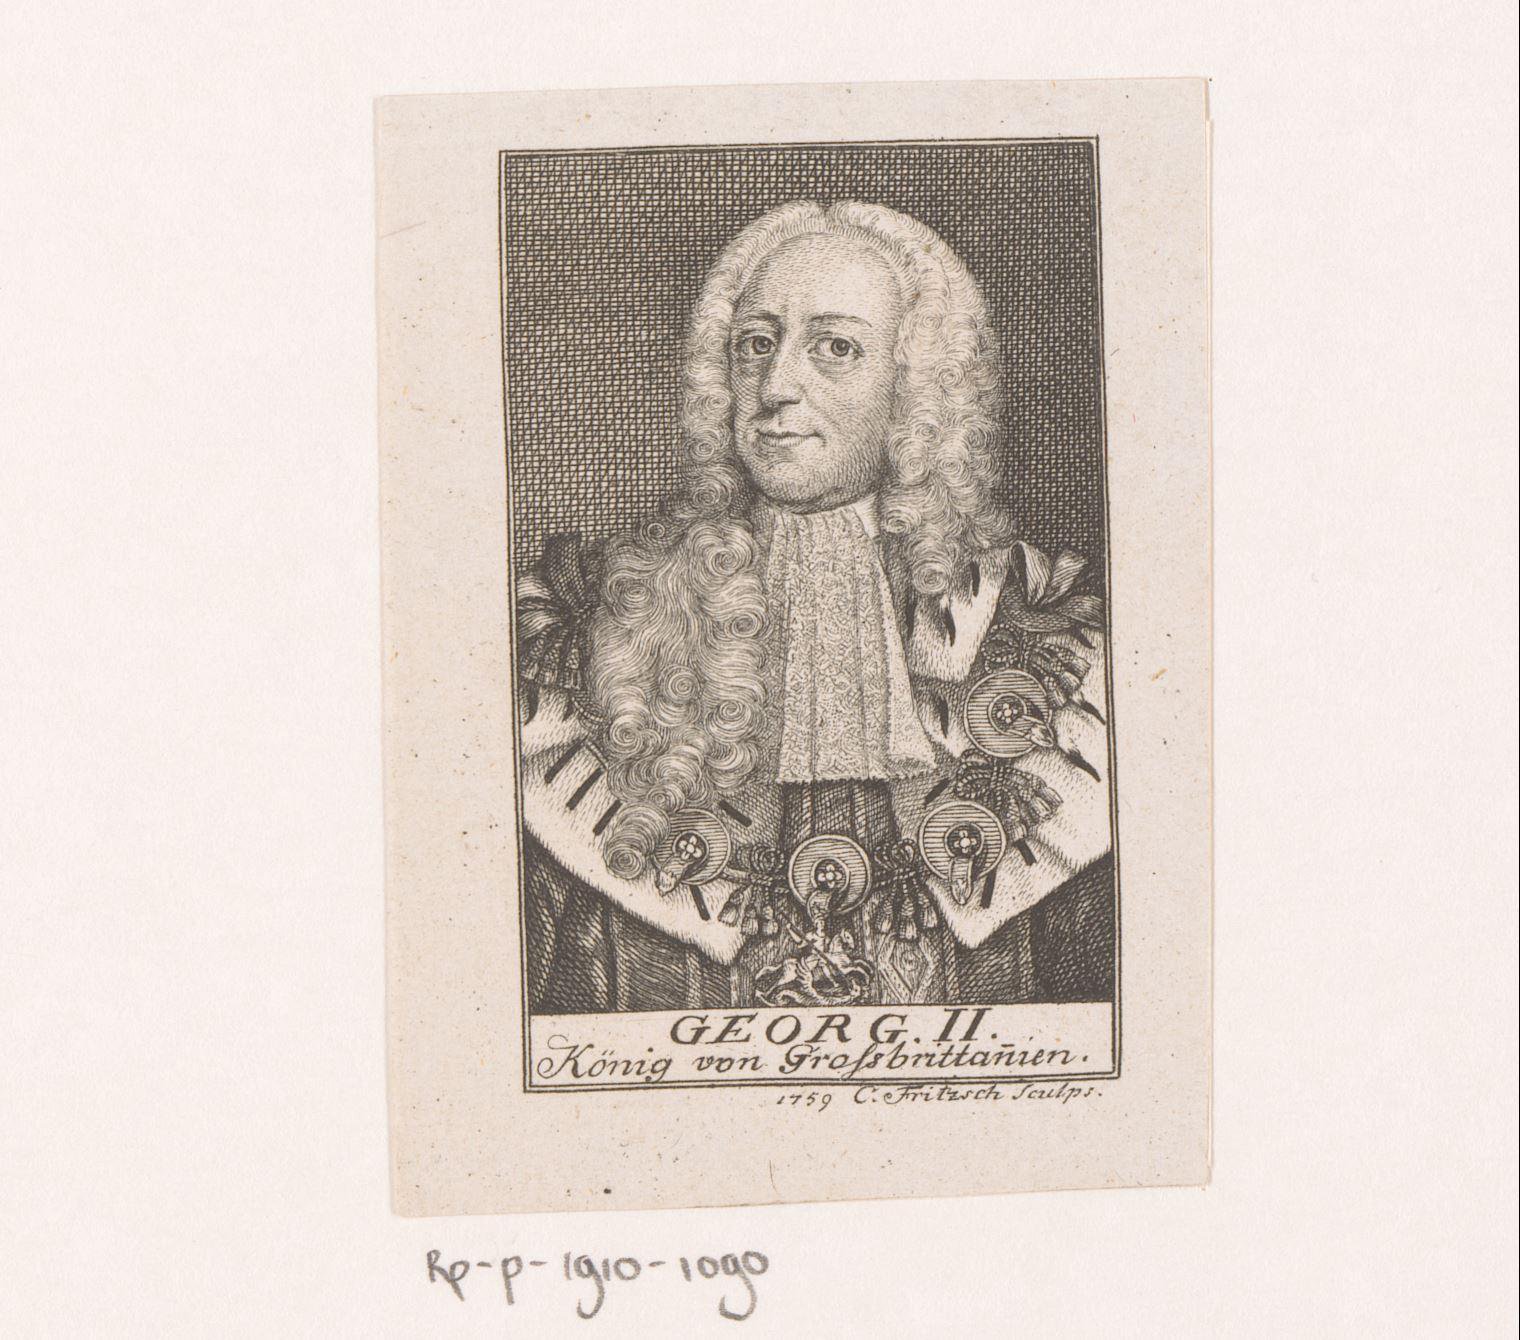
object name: print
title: Portret van Georg II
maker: johann christian gottfried fritzsch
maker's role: print maker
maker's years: 1720-1802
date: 1759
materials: paper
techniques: engraving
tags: london, historical persons, ruler, sovereign, the warrior martyr george (georgius); possible attributes: banner (red cross on white field), (red) cross, dragon, (white) horse, broken lance, shield (with cross), sword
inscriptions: collector's mark: Lugt 2228